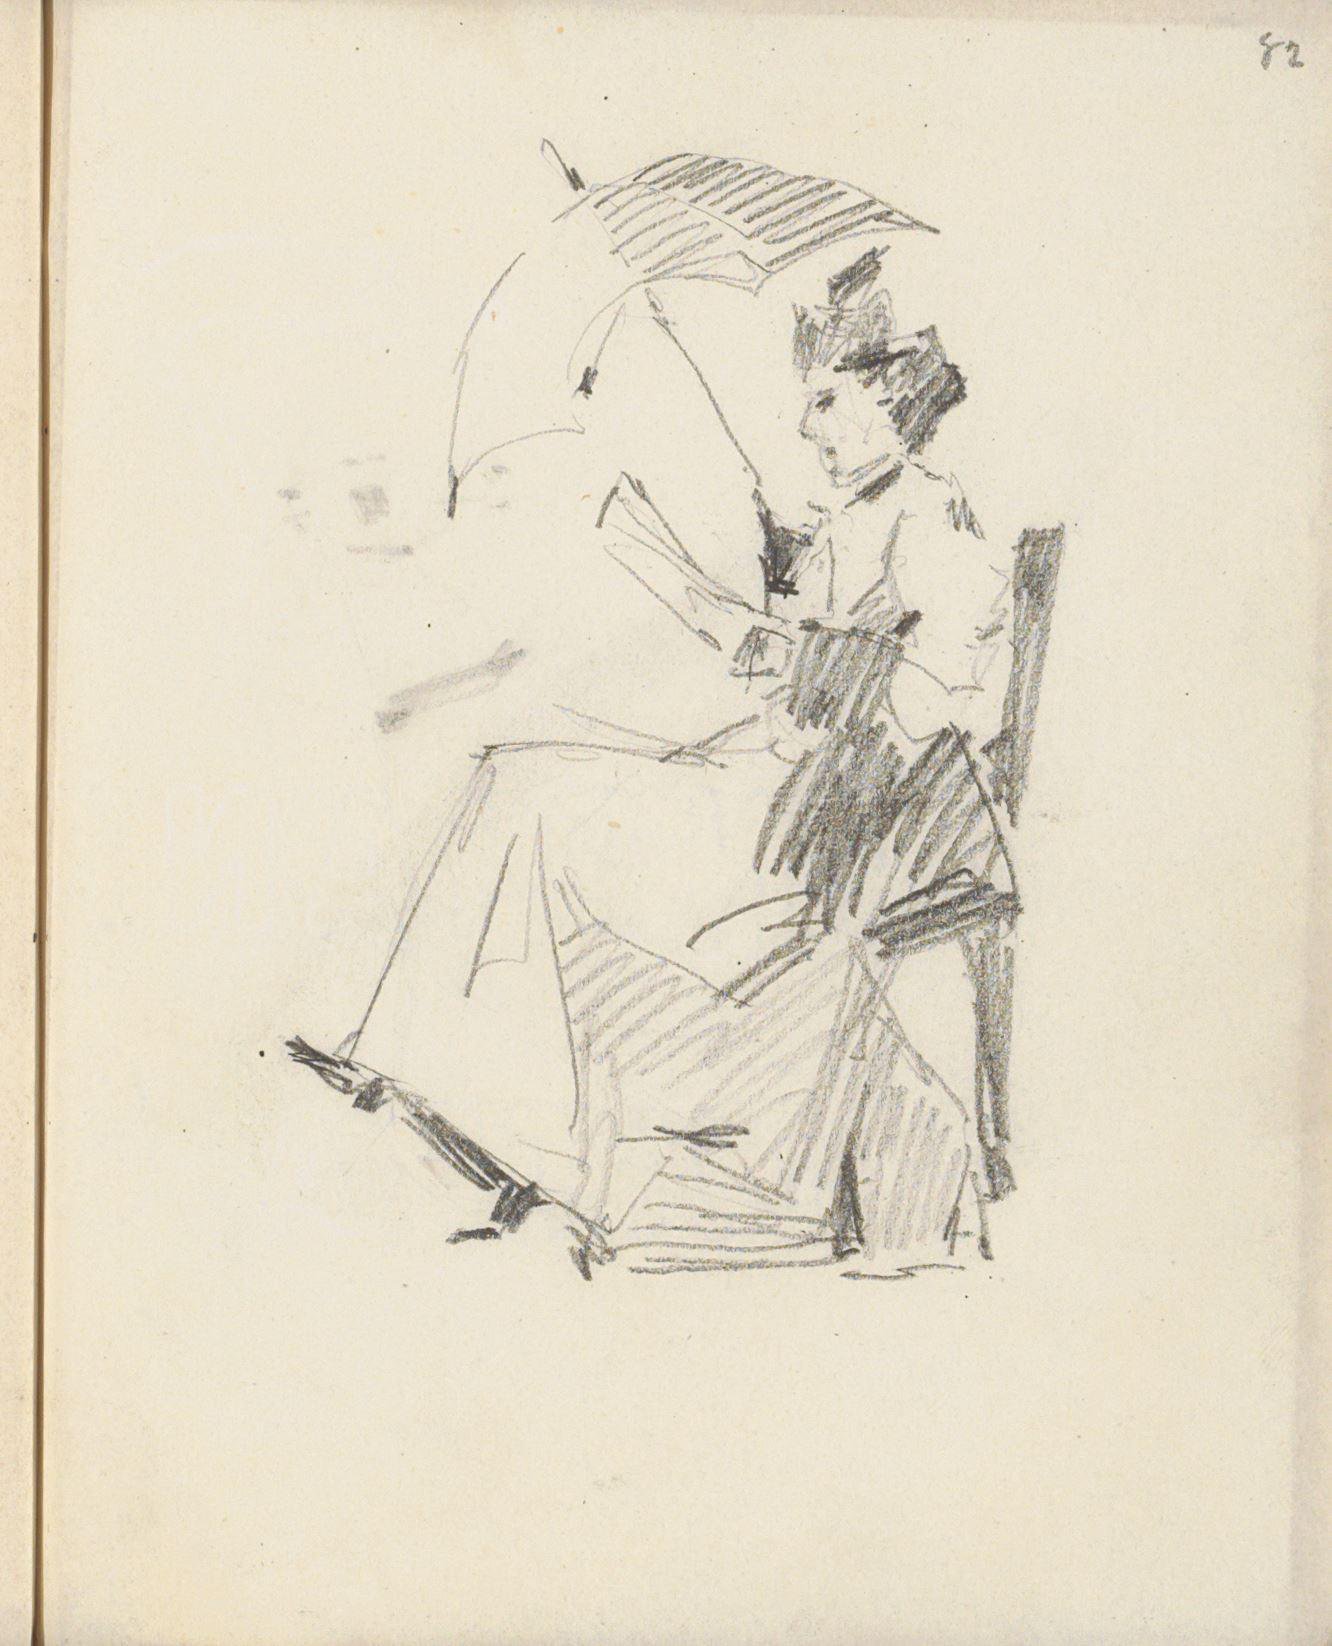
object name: sketchbook leaf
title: Lezende vrouw met een parasol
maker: alfred william rich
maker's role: draughtsman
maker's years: 1856-1921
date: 1892-1893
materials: paper, pencil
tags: reading, sitting figure - aa - female human figure, parasol, sunshade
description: Blad 82 recto uit een schetsboek met 86 bladen.